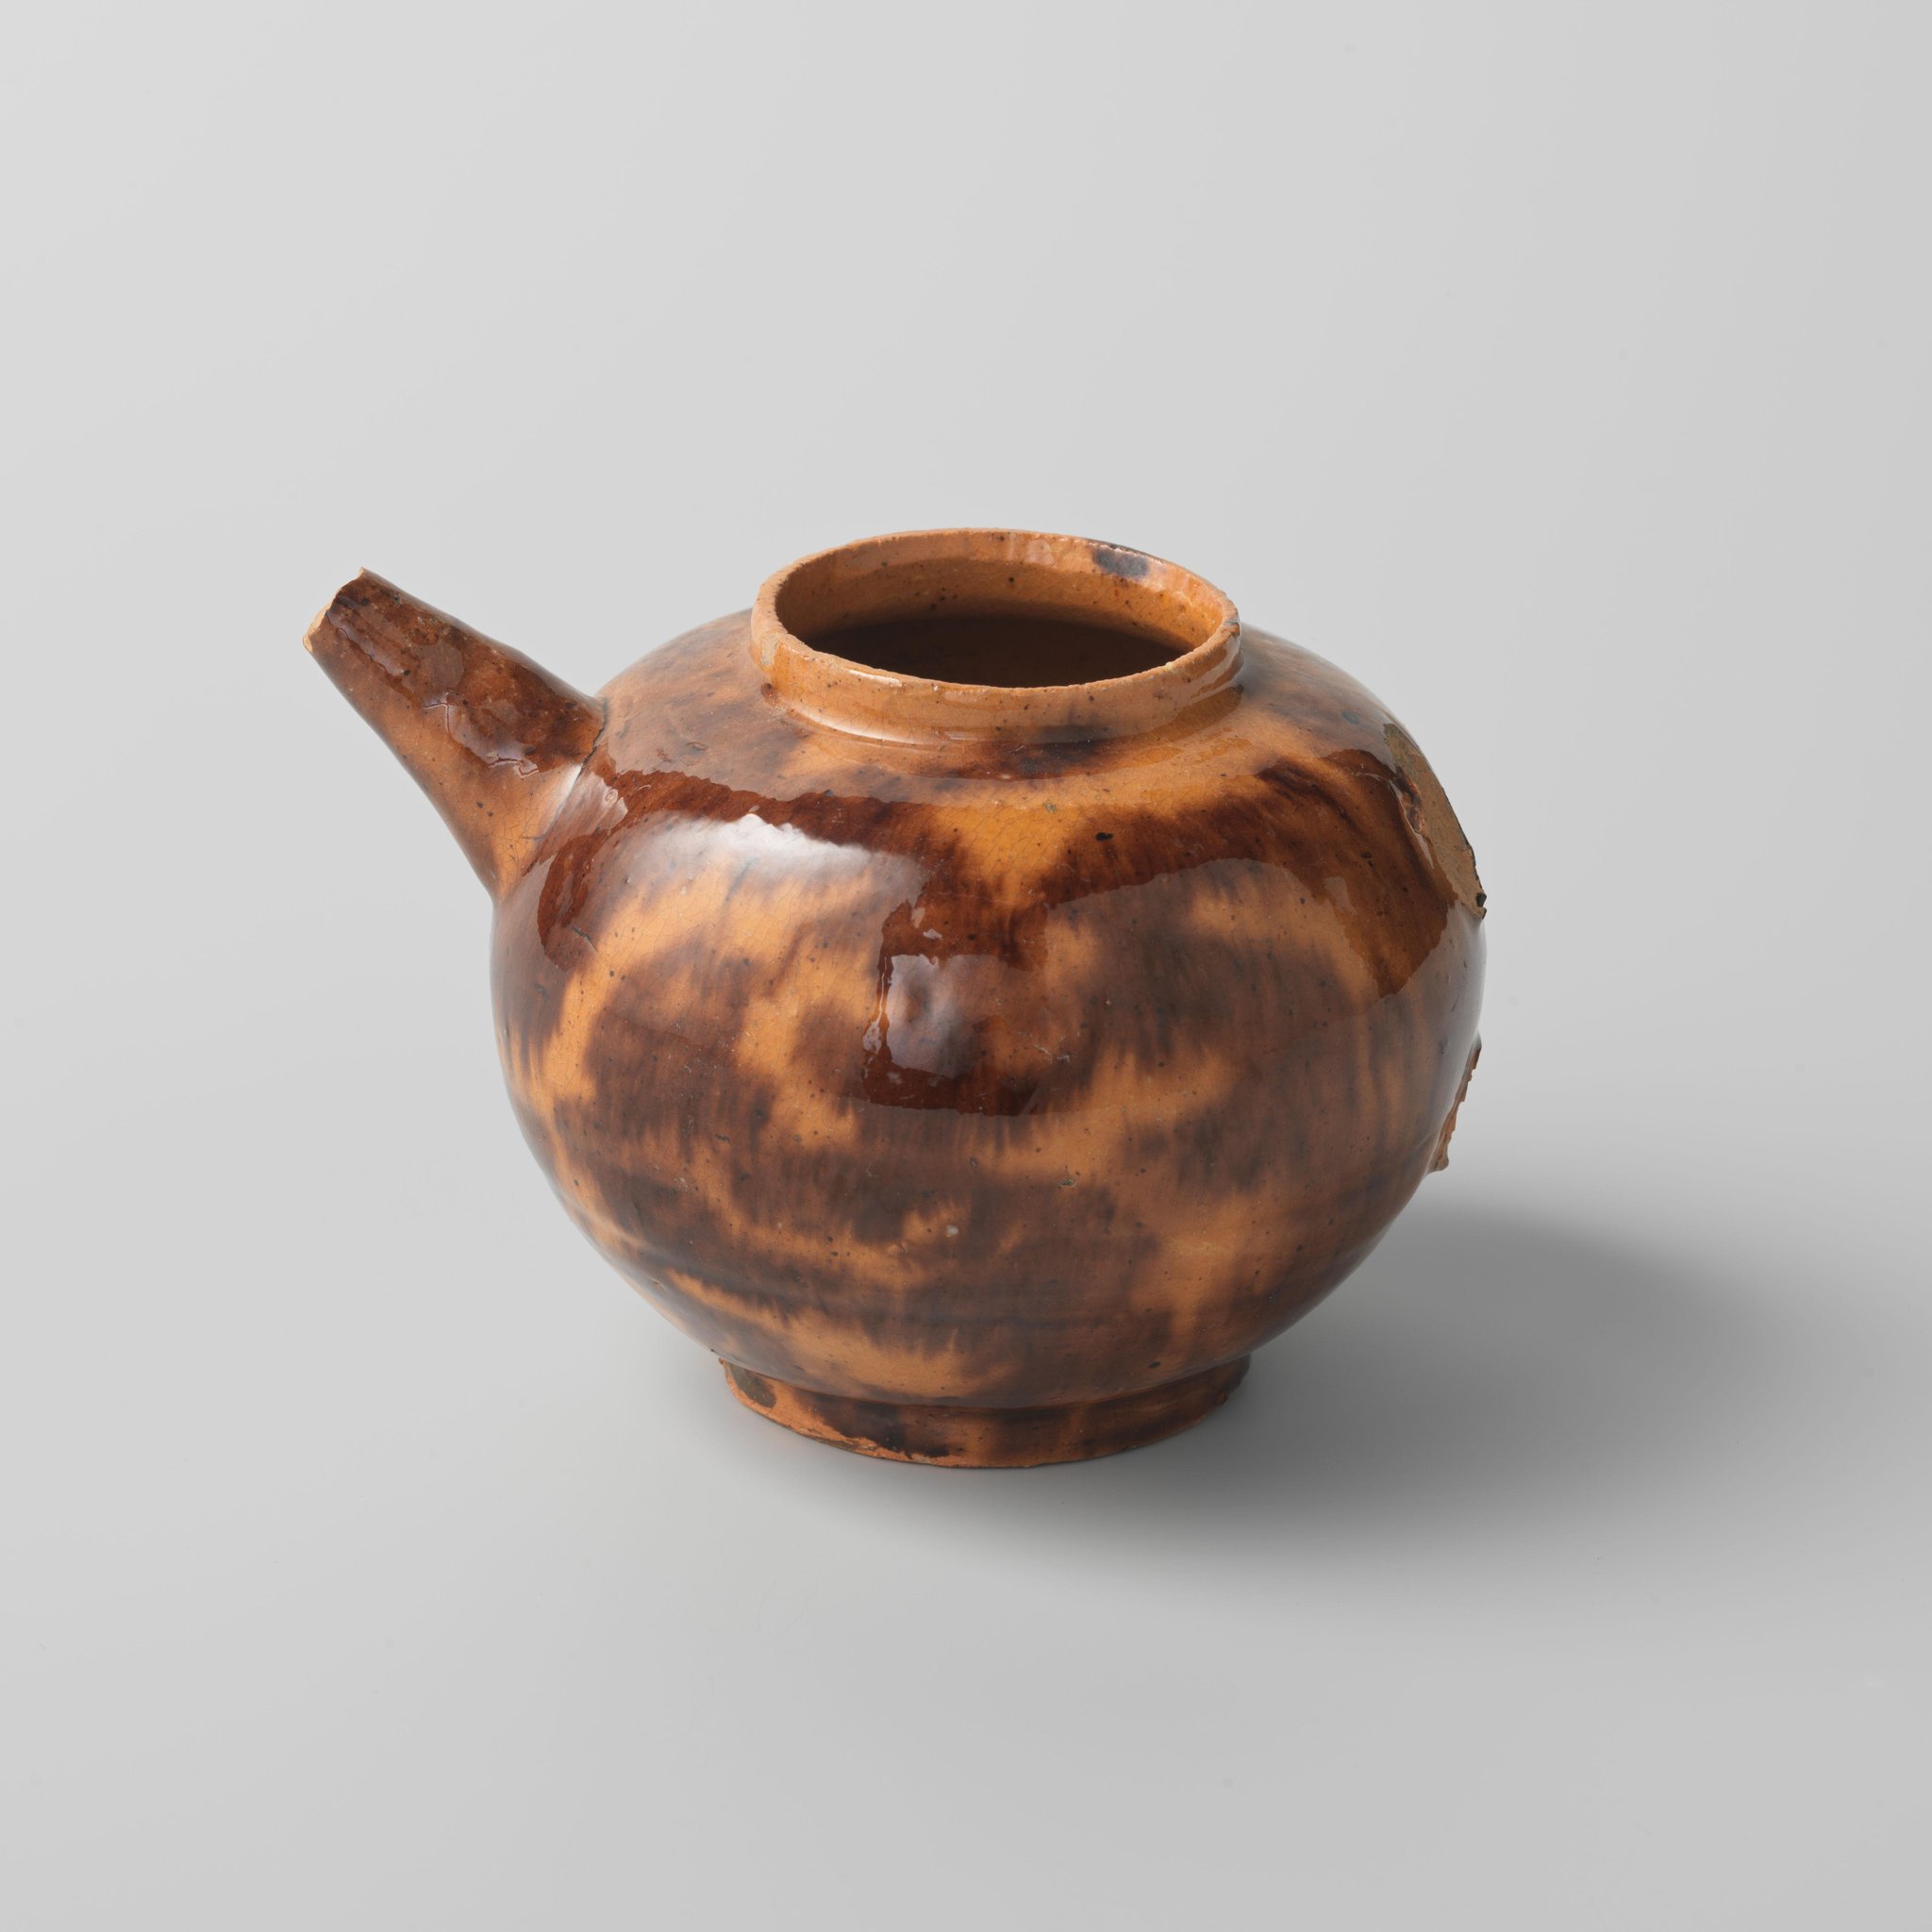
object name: teapot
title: Theepot met een versiering van bruine vlekken (De Caluwe bakafval)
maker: jacobus de caluwe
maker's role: plateelbakkerij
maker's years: -1730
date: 1700-1725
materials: earthenware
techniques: firing, vitrification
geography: delft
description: Toegeschreven aan Jacobus de Caluwe, omdat dit voorwerp samen met gemerkte stukken (‘Jacobus De Caluwe’ en rennend hert) gevonden is op de plaats waar zich De Caluwes tweede werkplaats bevond. Er is een duidelijke stilistische overeenkomst tussen de gemerkte en niet gemerkte voorwerpen uit deze archeologische vondst.